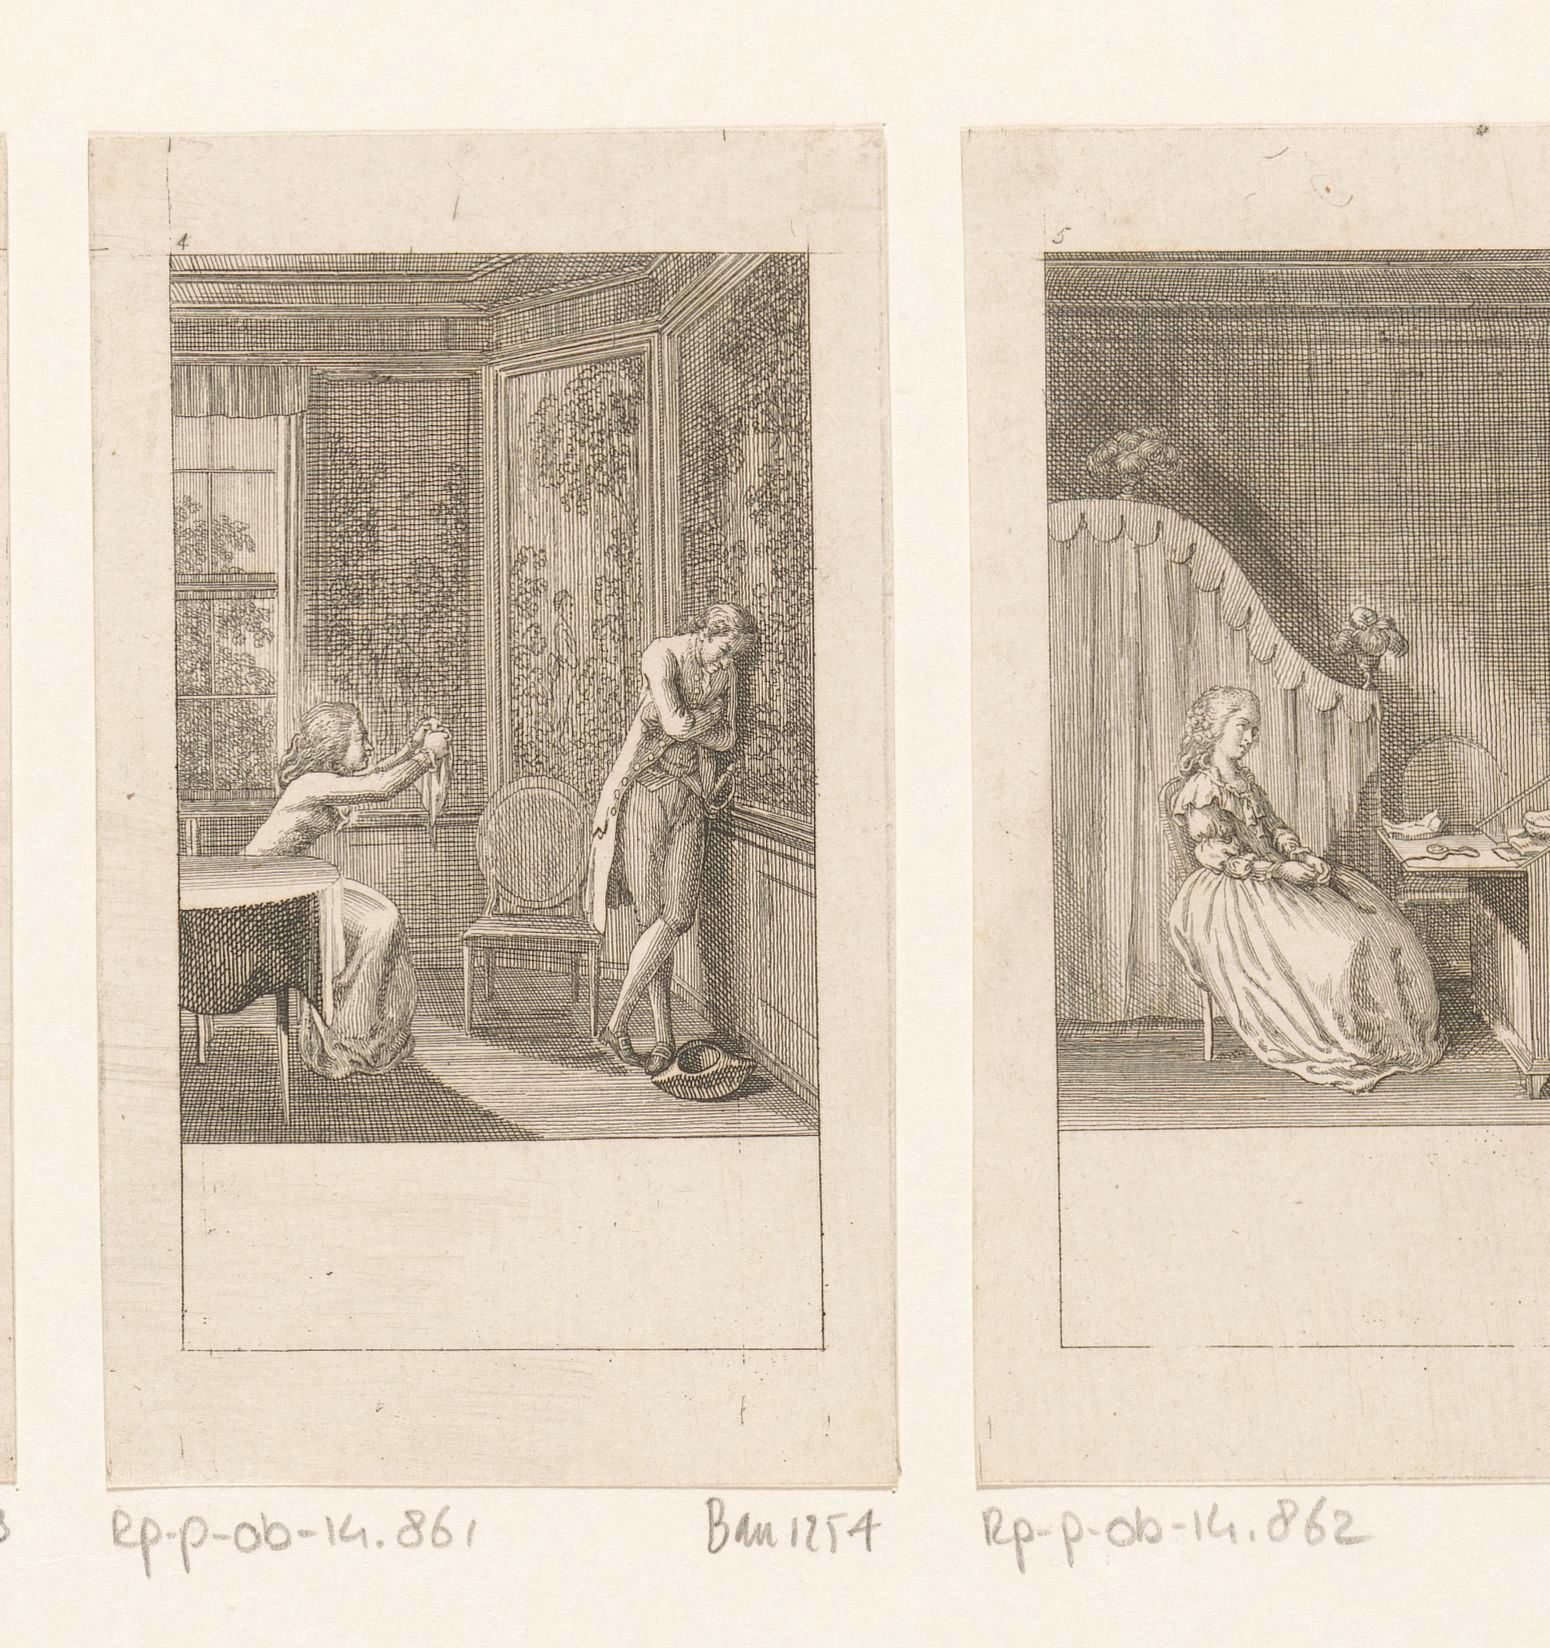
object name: print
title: Caroline vertelt Lindorf dat ze al uitgehuwelijkt is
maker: daniel nikolaus chodowiecki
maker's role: draughtsman, print maker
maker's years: 1726-1801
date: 1786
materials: paper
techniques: etching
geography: berlin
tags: literature, betrothal and marriage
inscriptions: collector's mark: Lugt 2228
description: Vervaardigd voor 'Caroline von Lichtfield' van Isabelle de Montolieu. Latere staat gebruikt voor: Gothaischer Hof Kalender zum Nutzen und Vergnügen eingerichtet auf das Jahr 1788. Gotha: C. W. Ettinger, [1787].